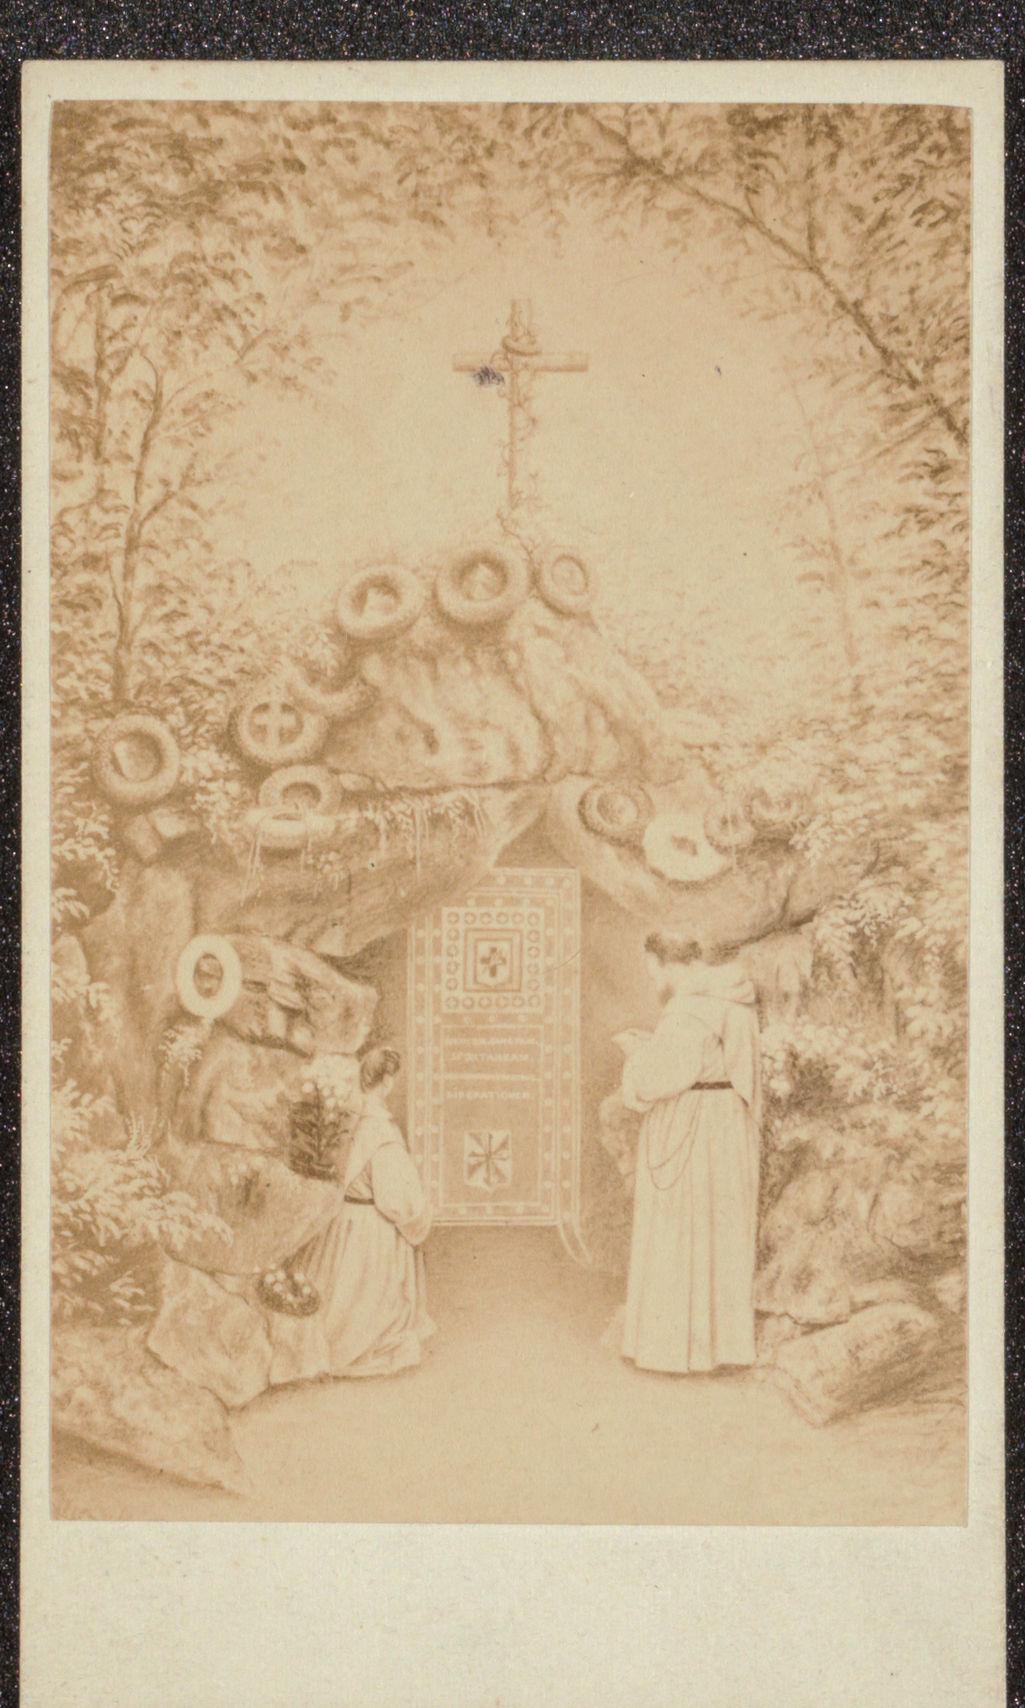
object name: photograph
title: Reproductie van (vermoedelijk) een tekening van twee geestelijken bij een graf in een rots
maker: Anonymous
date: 1871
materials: cardboard, paper, photographic support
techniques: albumen print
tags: priest (roman catholic)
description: Onderdeel van Herdenkingsalbum van rooms-katholieke geestelijken gevallen tijdens de Commune van Parijs.